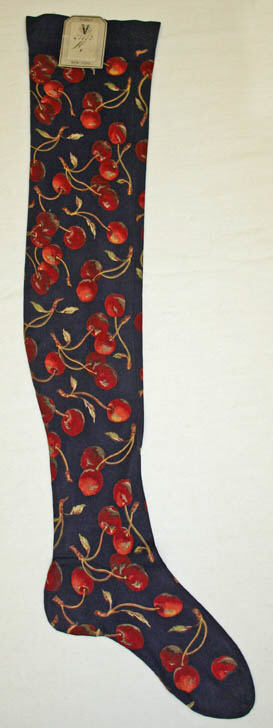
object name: stocking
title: Stockings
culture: french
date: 1870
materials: cotton